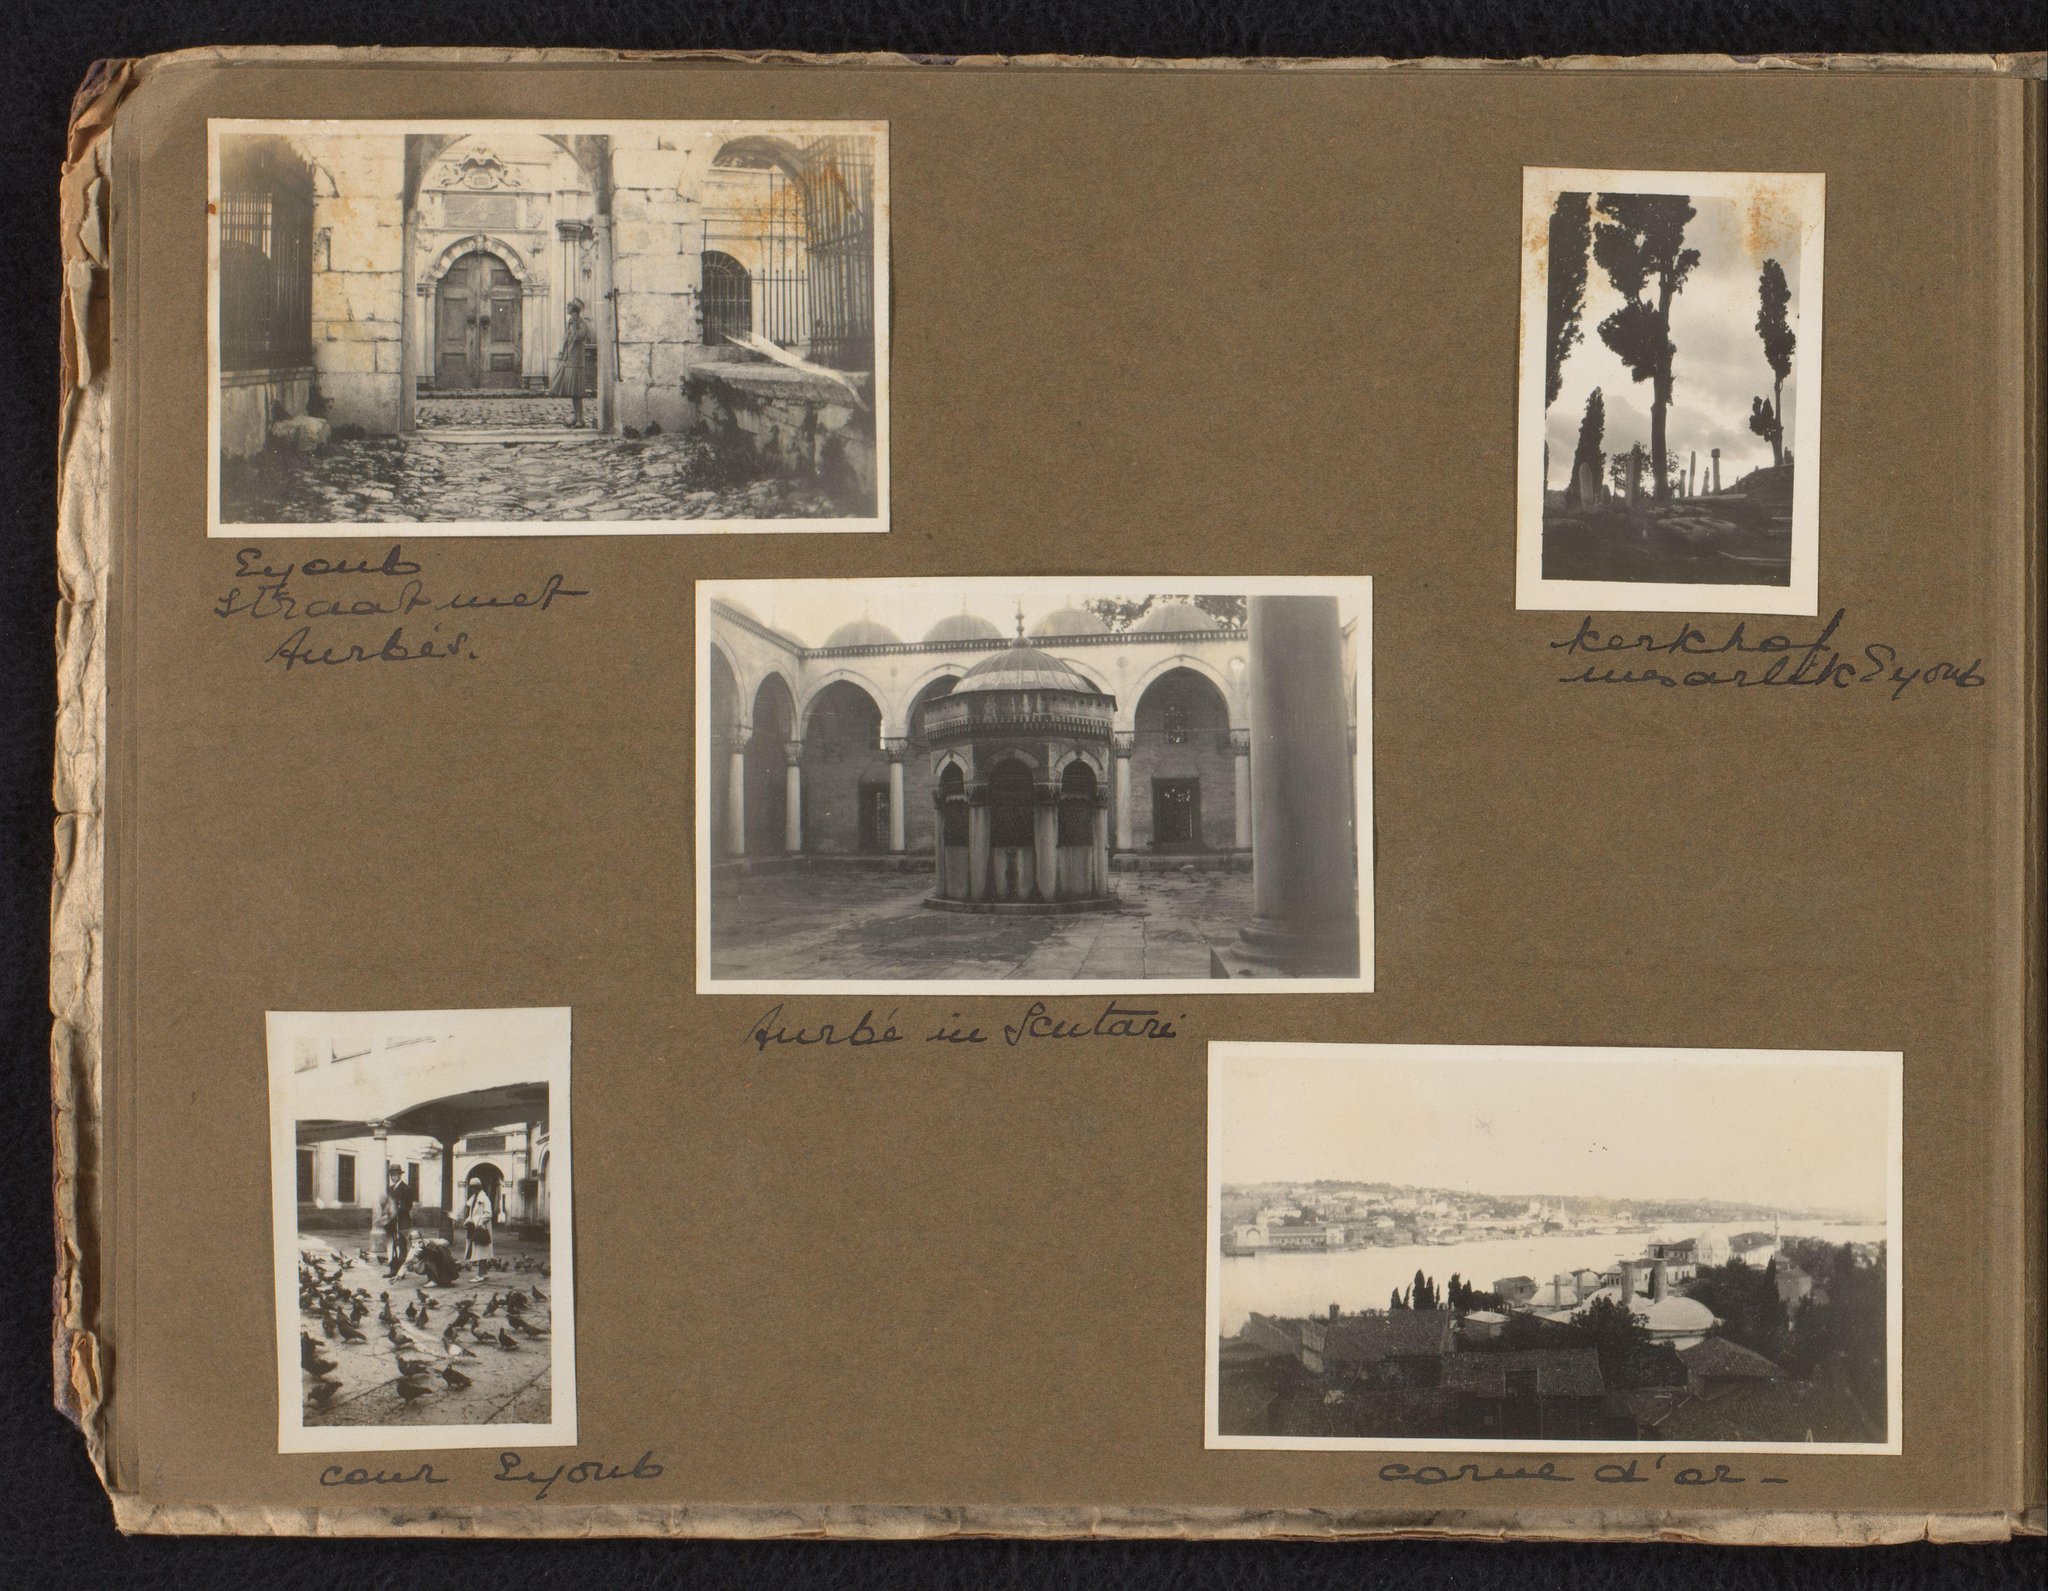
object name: album leaf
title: Vijf foto's van Istanboel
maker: carolina frederika onnen (lien/loen)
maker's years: 1896-1983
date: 1909-1926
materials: paper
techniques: gelatin silver print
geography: istanbul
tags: city-view in general; 'veduta', churchyard, cemetery, street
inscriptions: inscription: ‘corne d'or’, inscription: ‘Eyoub/ straat met/ Aurbés’, inscription: ‘cour Eyoub’, inscription: ‘kerkhof/ mesarlik Eyoub’, inscription: ‘Aurbé in Scutari’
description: Deze foto's maken deel uit van een album.